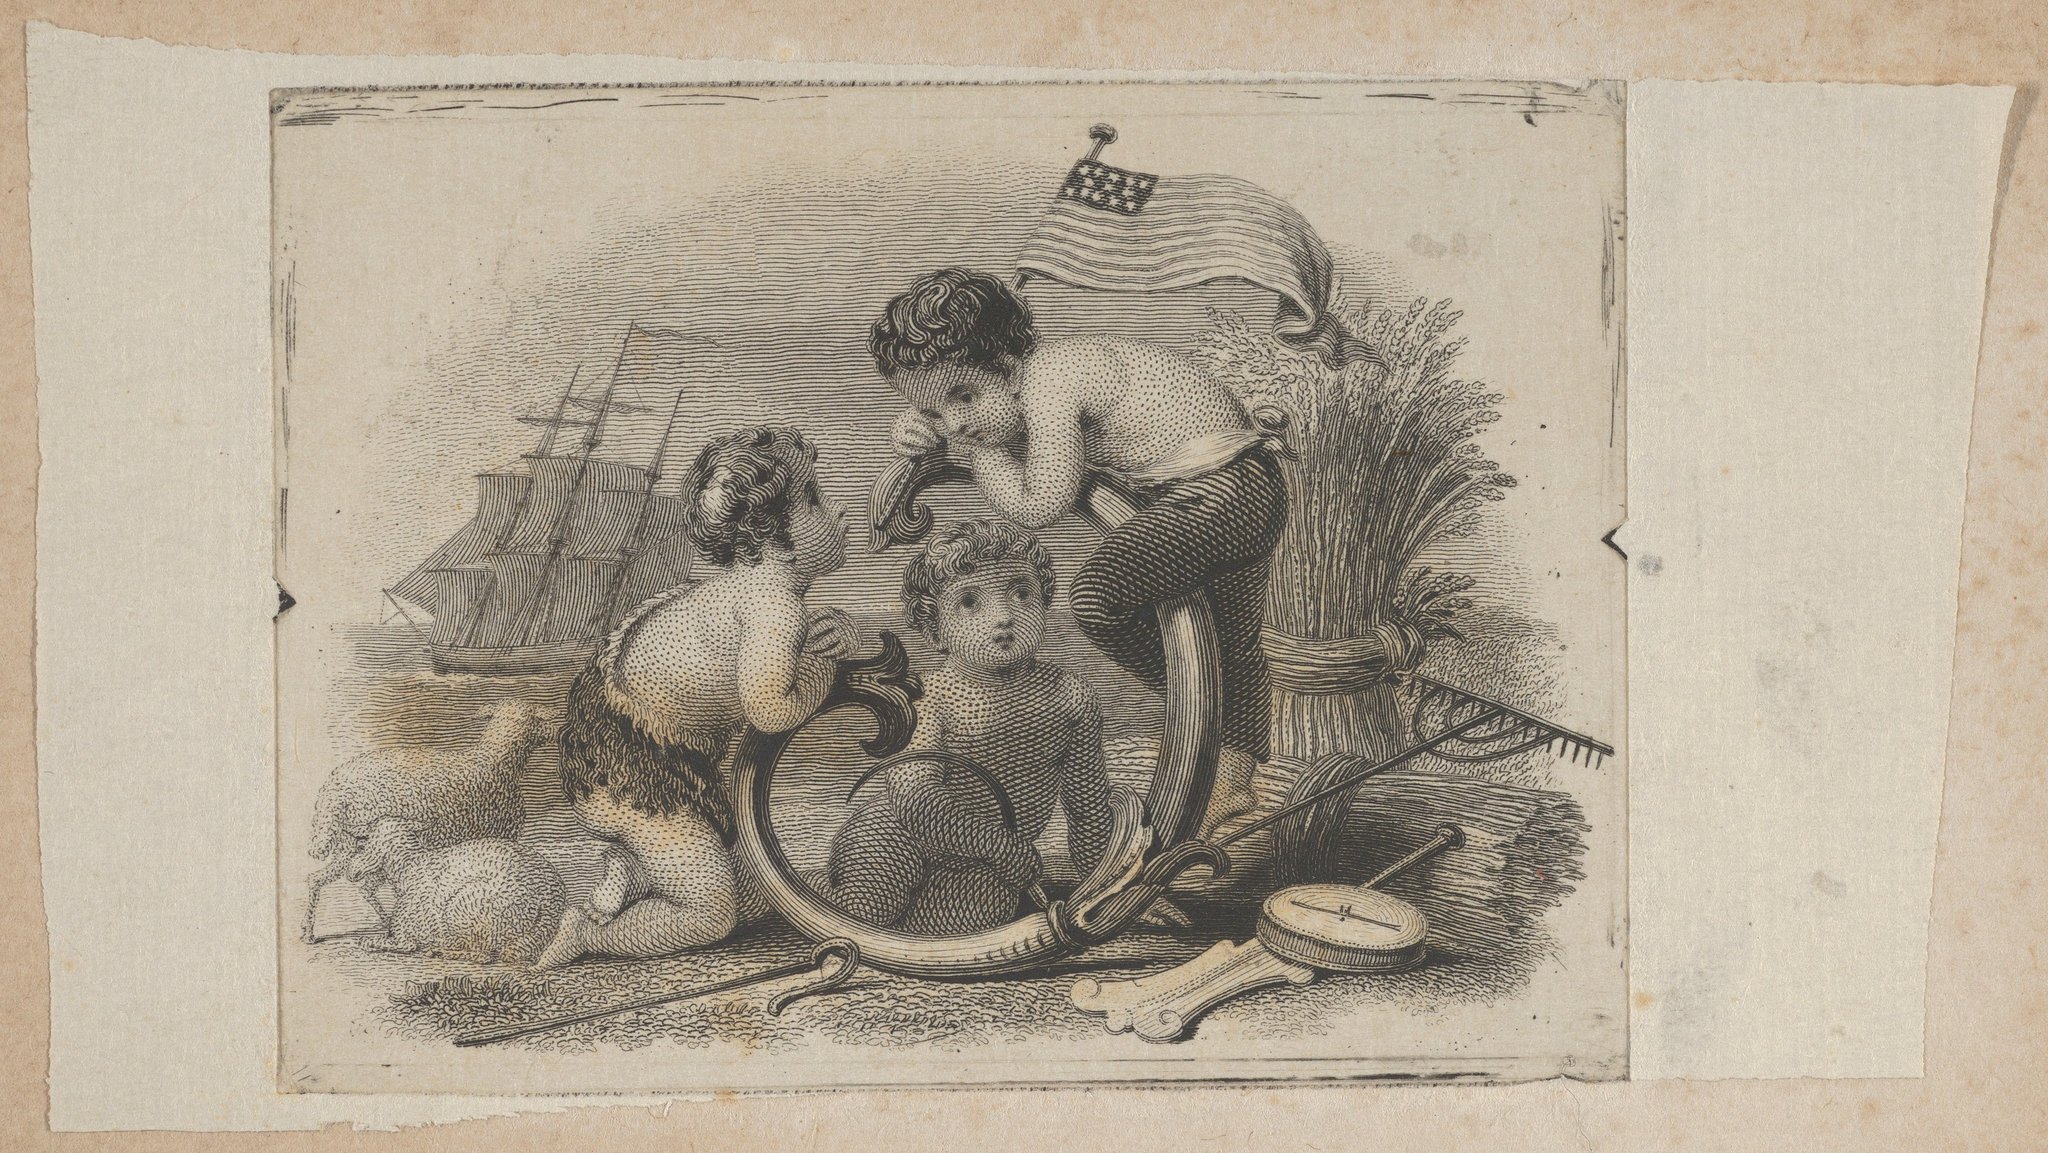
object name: print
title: Banknote vignette with three putti as a shepherd, a farmer, and a sailor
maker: asher brown durand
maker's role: artist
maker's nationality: american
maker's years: 1796-1886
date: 1824-1837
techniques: engraving, etching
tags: putti,sheep,boats